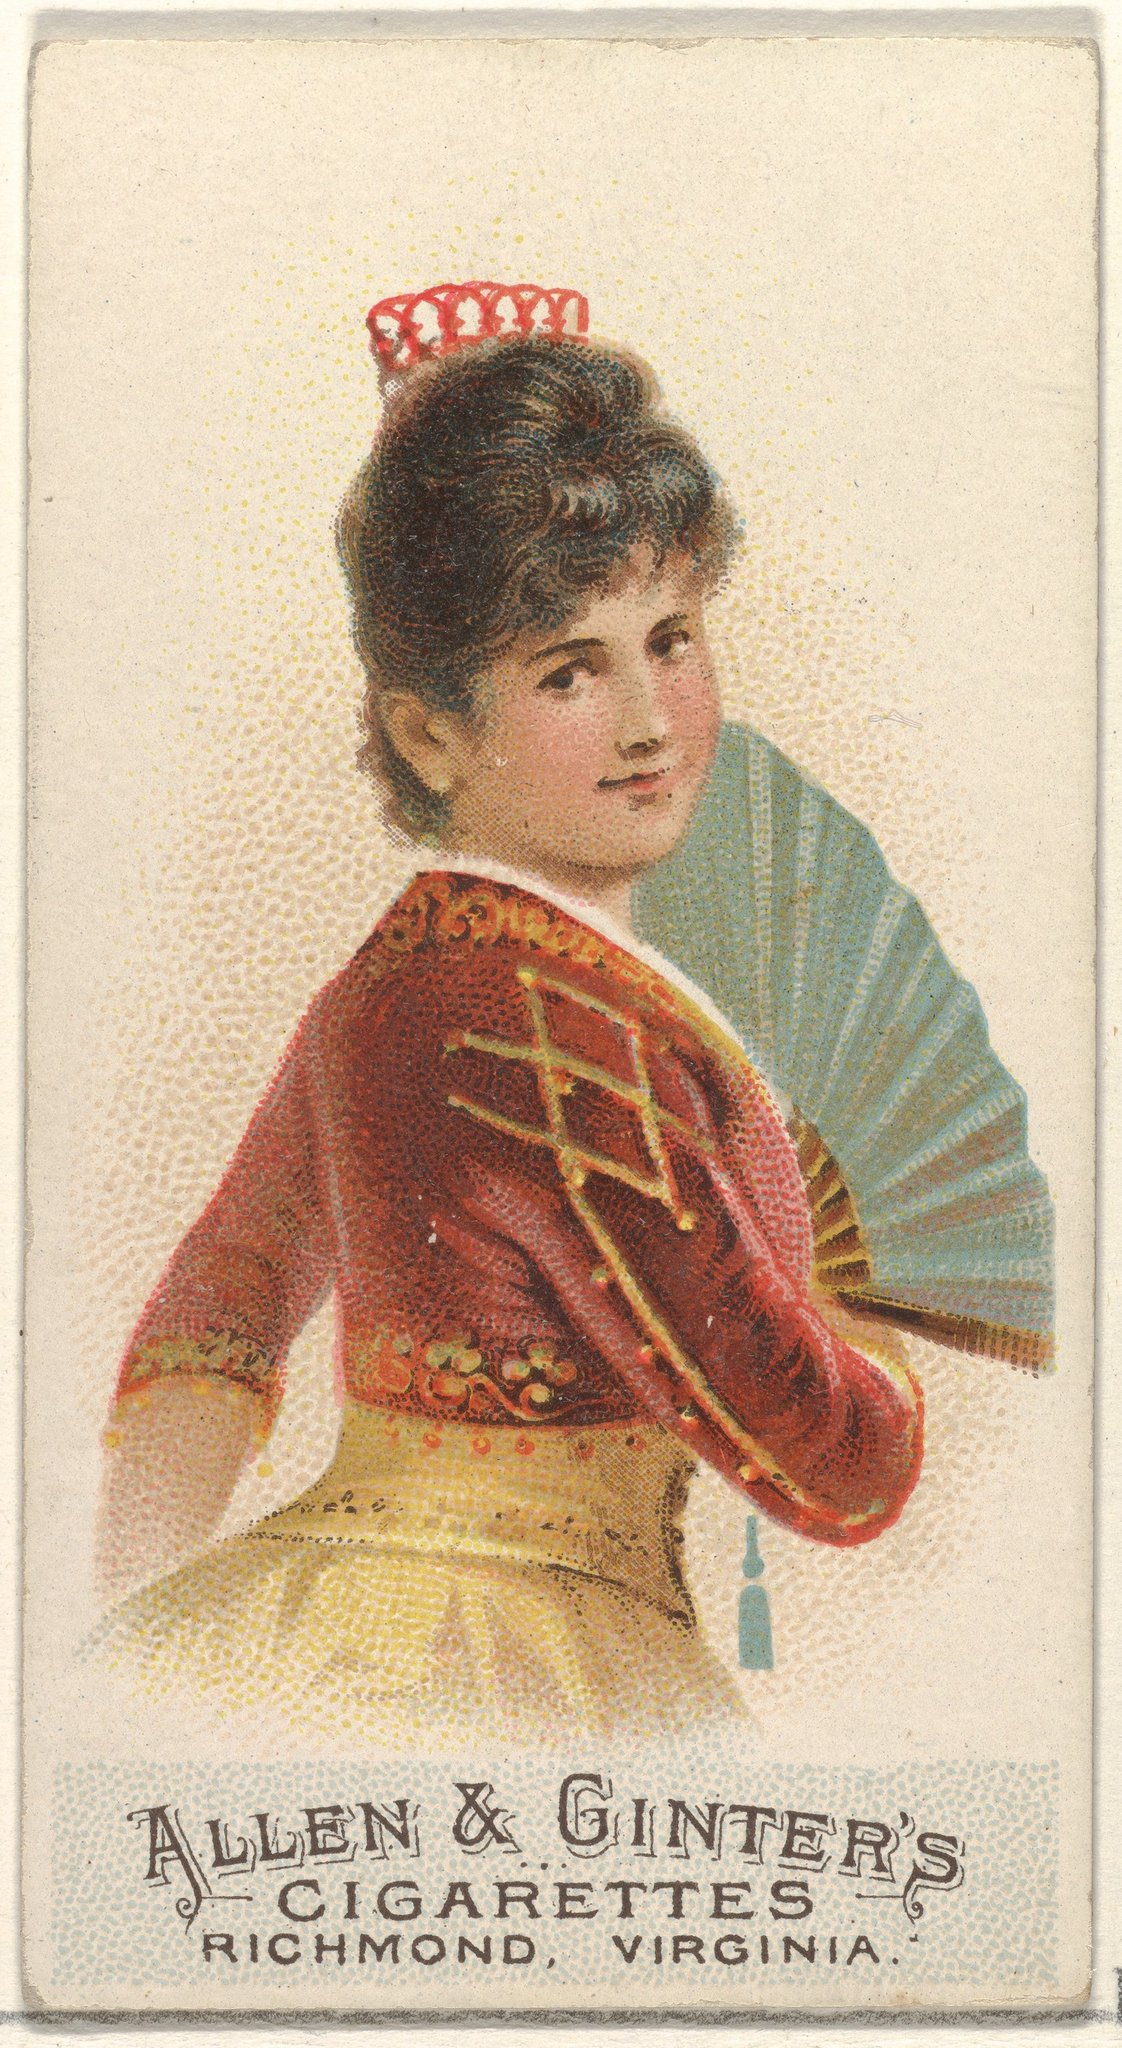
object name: print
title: Plate 44, from the Fans of the Period series (N7) for Allen & Ginter Cigarettes Brands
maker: allen & ginter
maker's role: publisher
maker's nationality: american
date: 1889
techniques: color lithograph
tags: fans,women